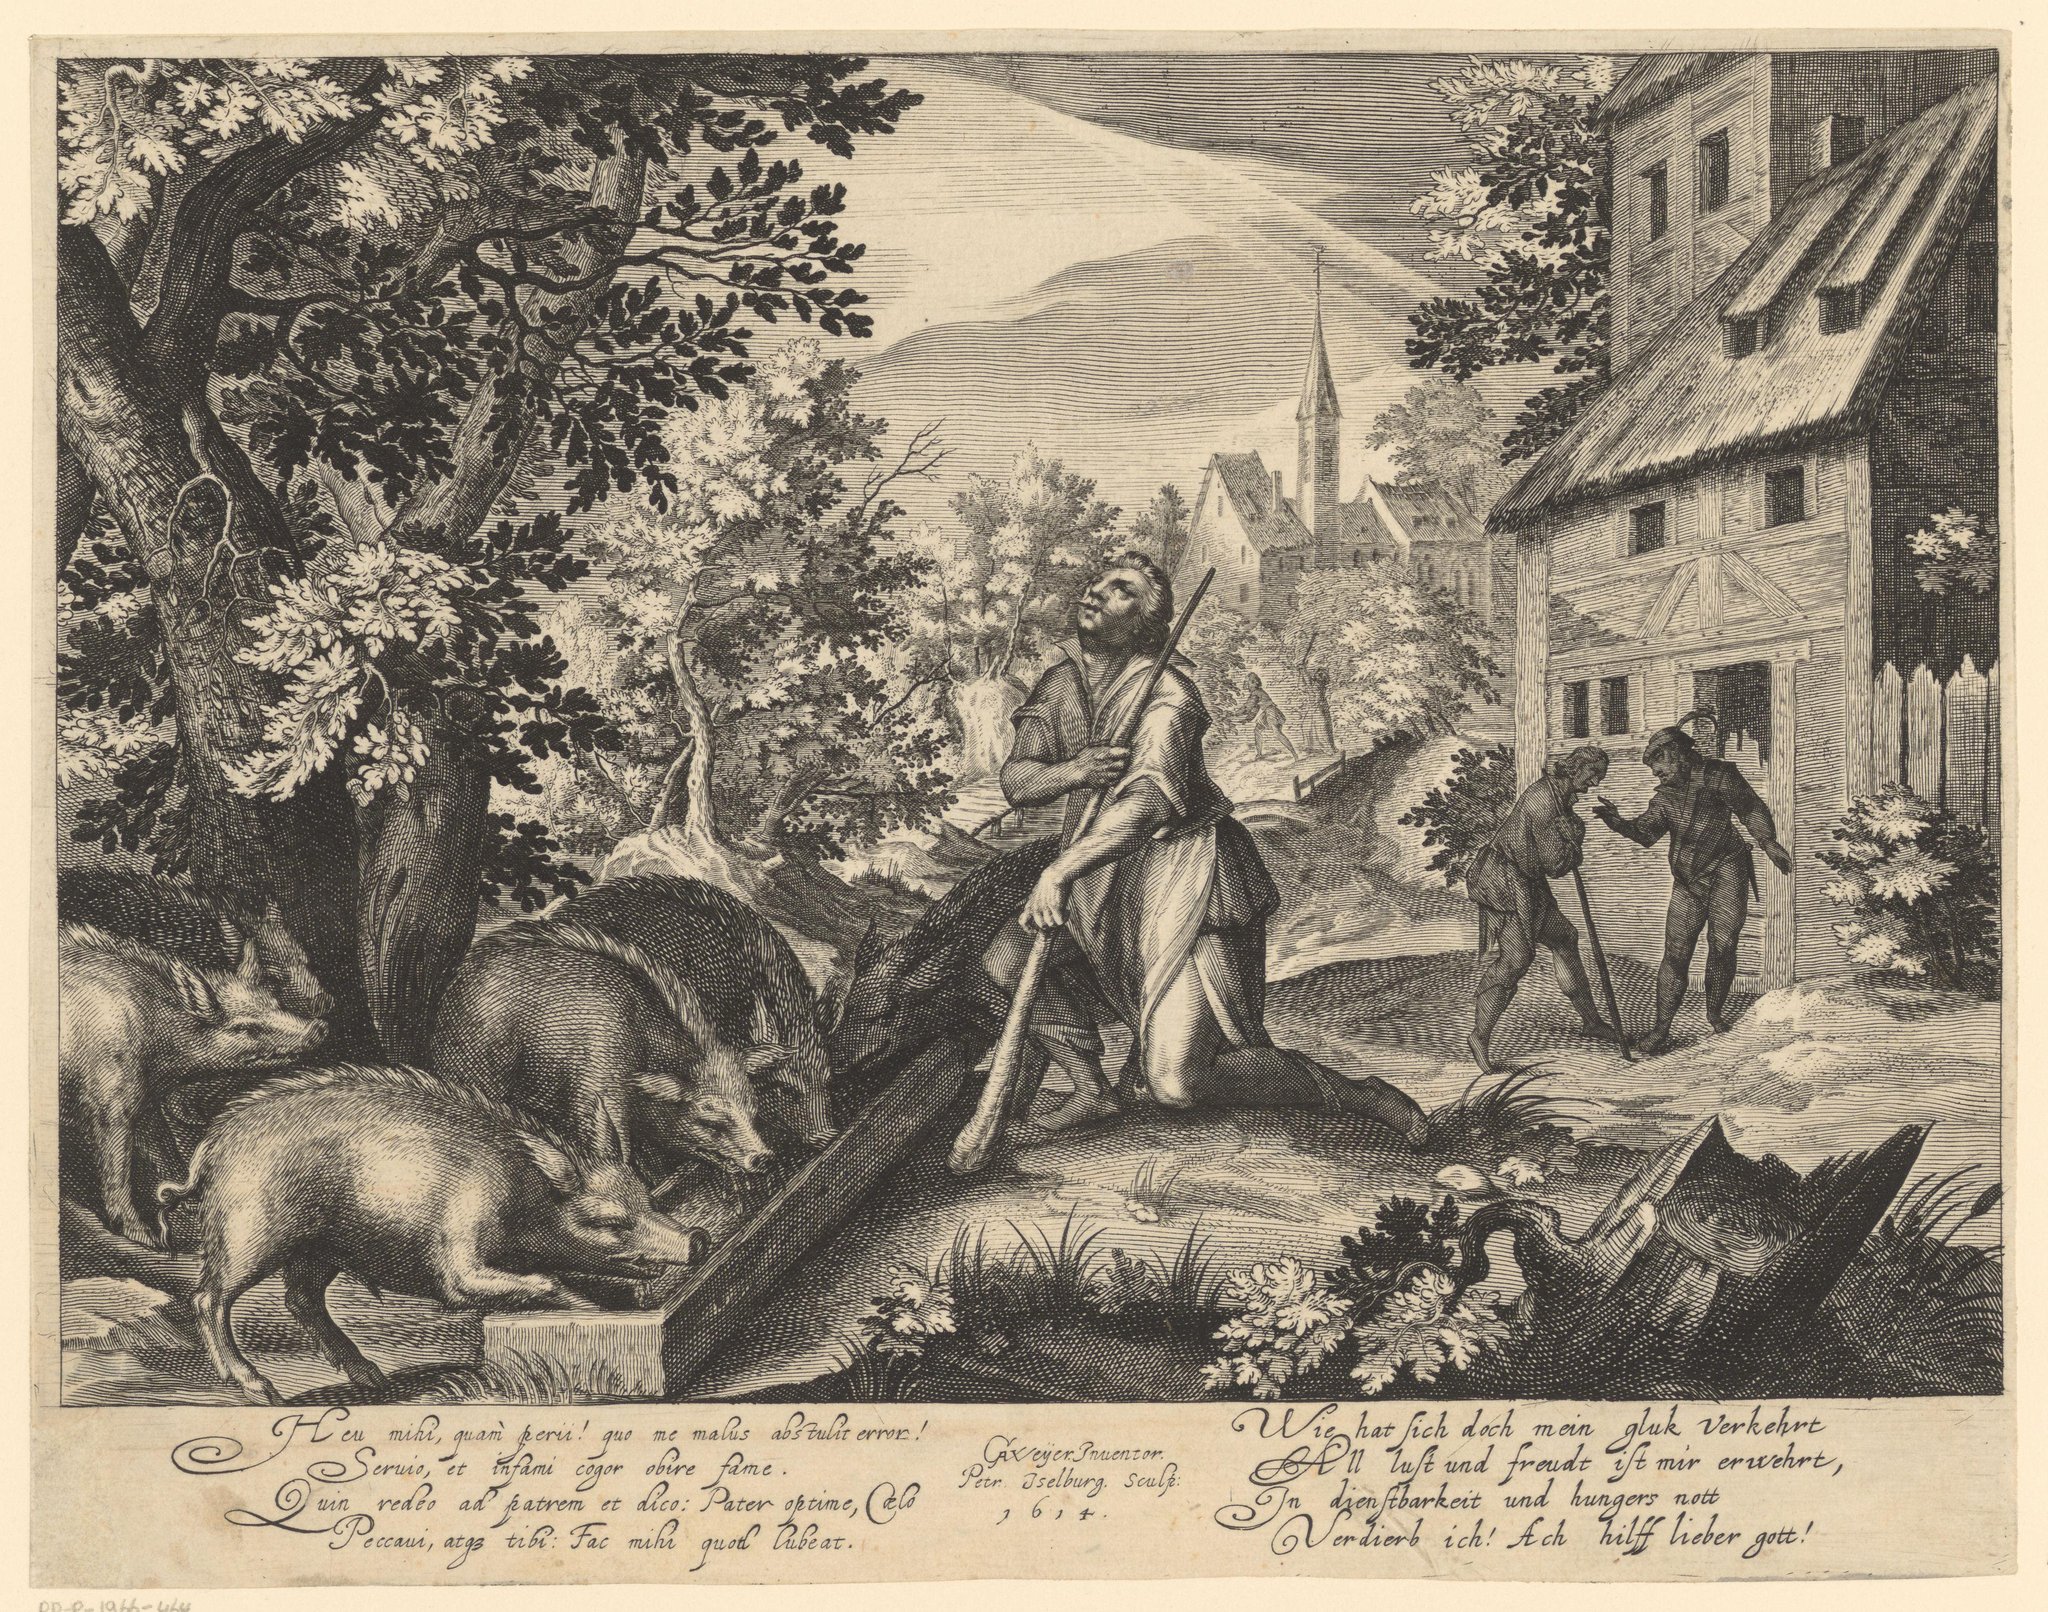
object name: print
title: Verloren zoon tussen de zwijnen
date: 1614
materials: paper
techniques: engraving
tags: the prodigal son repents his former life and prays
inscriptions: collector's mark: Lugt 2228, collector's mark: Lugt 1041c